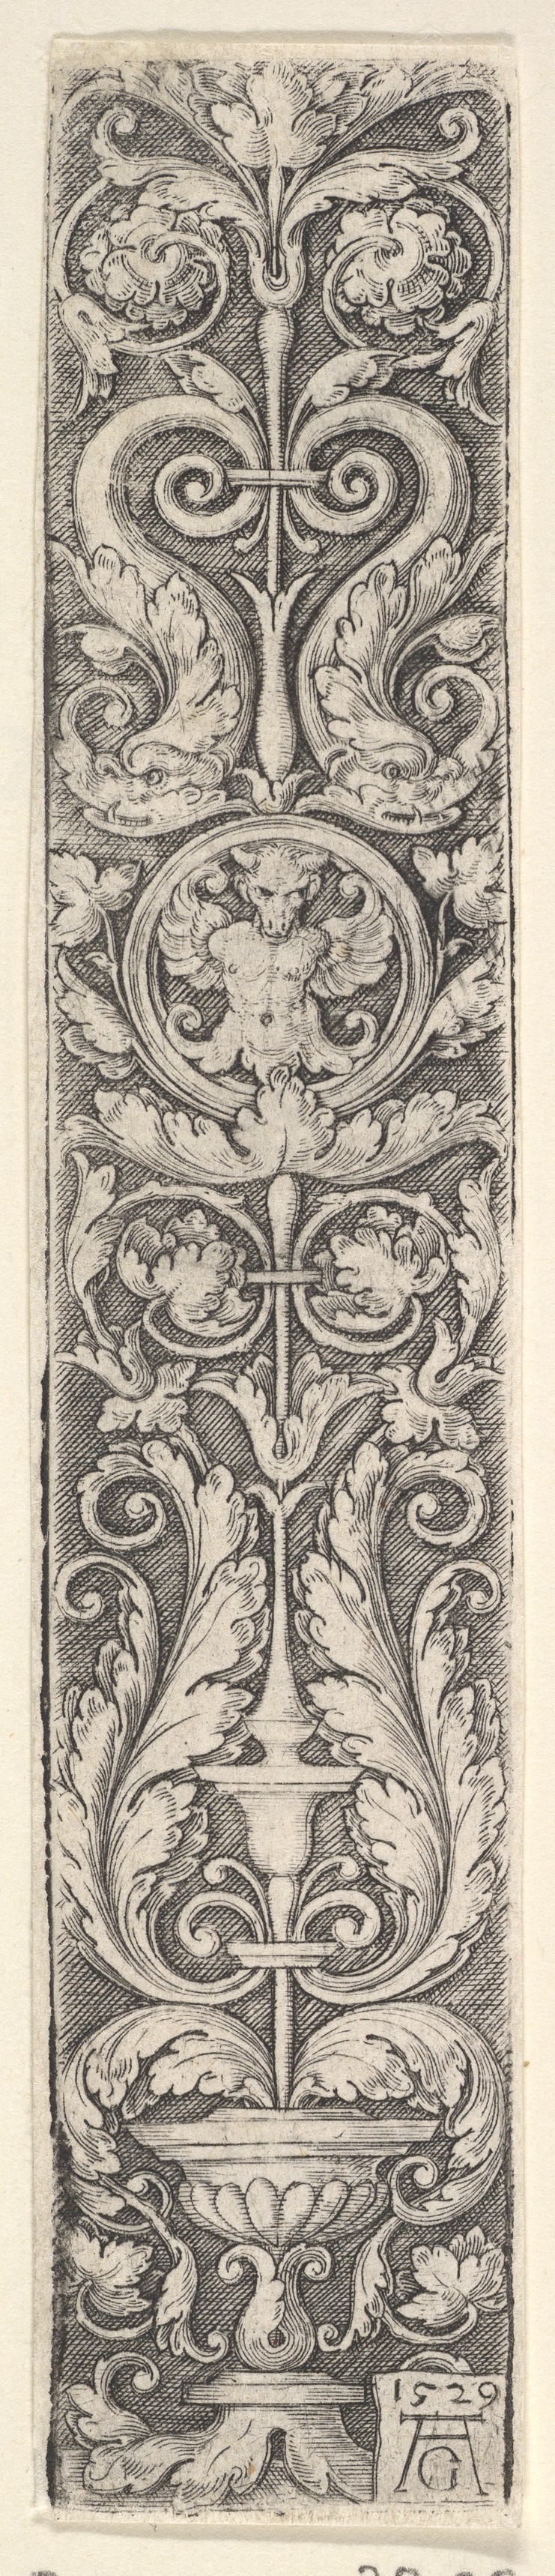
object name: print ornament architecture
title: Vertical Panel with a Candelabrum Containing a Medallion with a Centaur and a Pair of Dolphins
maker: heinrich aldegrever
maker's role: artist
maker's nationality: german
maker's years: 1502-1561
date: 1529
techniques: engraving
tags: centaurs,dolphins